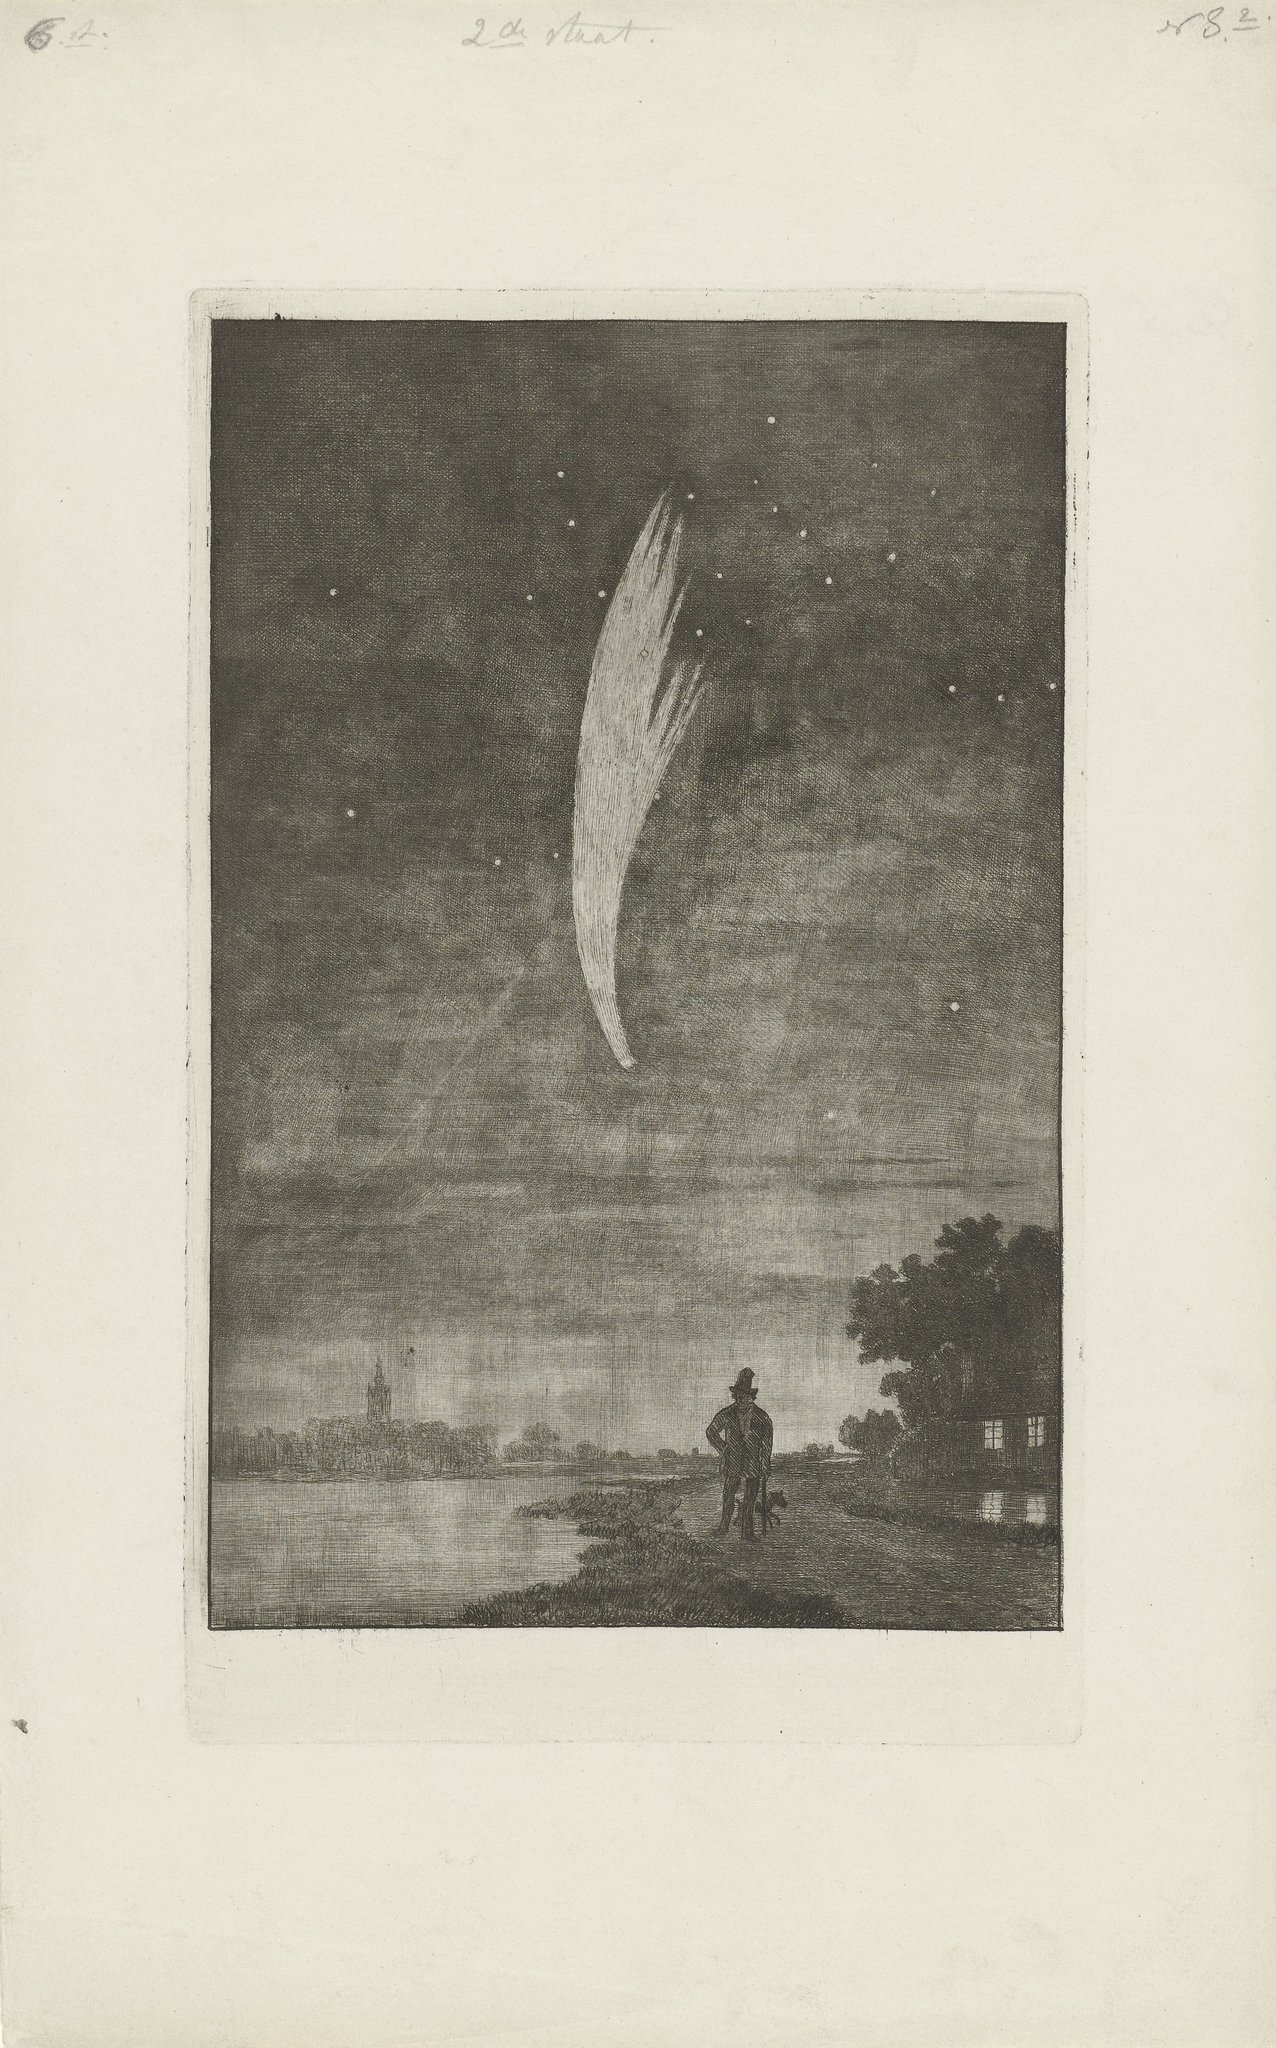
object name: print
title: De komeet van Donati, 1858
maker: cornelis van der griendt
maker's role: draughtsman, painter, print maker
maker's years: 1827-1918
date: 1858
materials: paper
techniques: etching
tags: comet, river (+ landscape with figures, staffage)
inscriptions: collector's mark: Lugt 2228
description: De komeet van Donati, 10 oktober 1858. Op de voorgrond een man met hond bij een rivier. Op de achtergrond links een kerktoren.